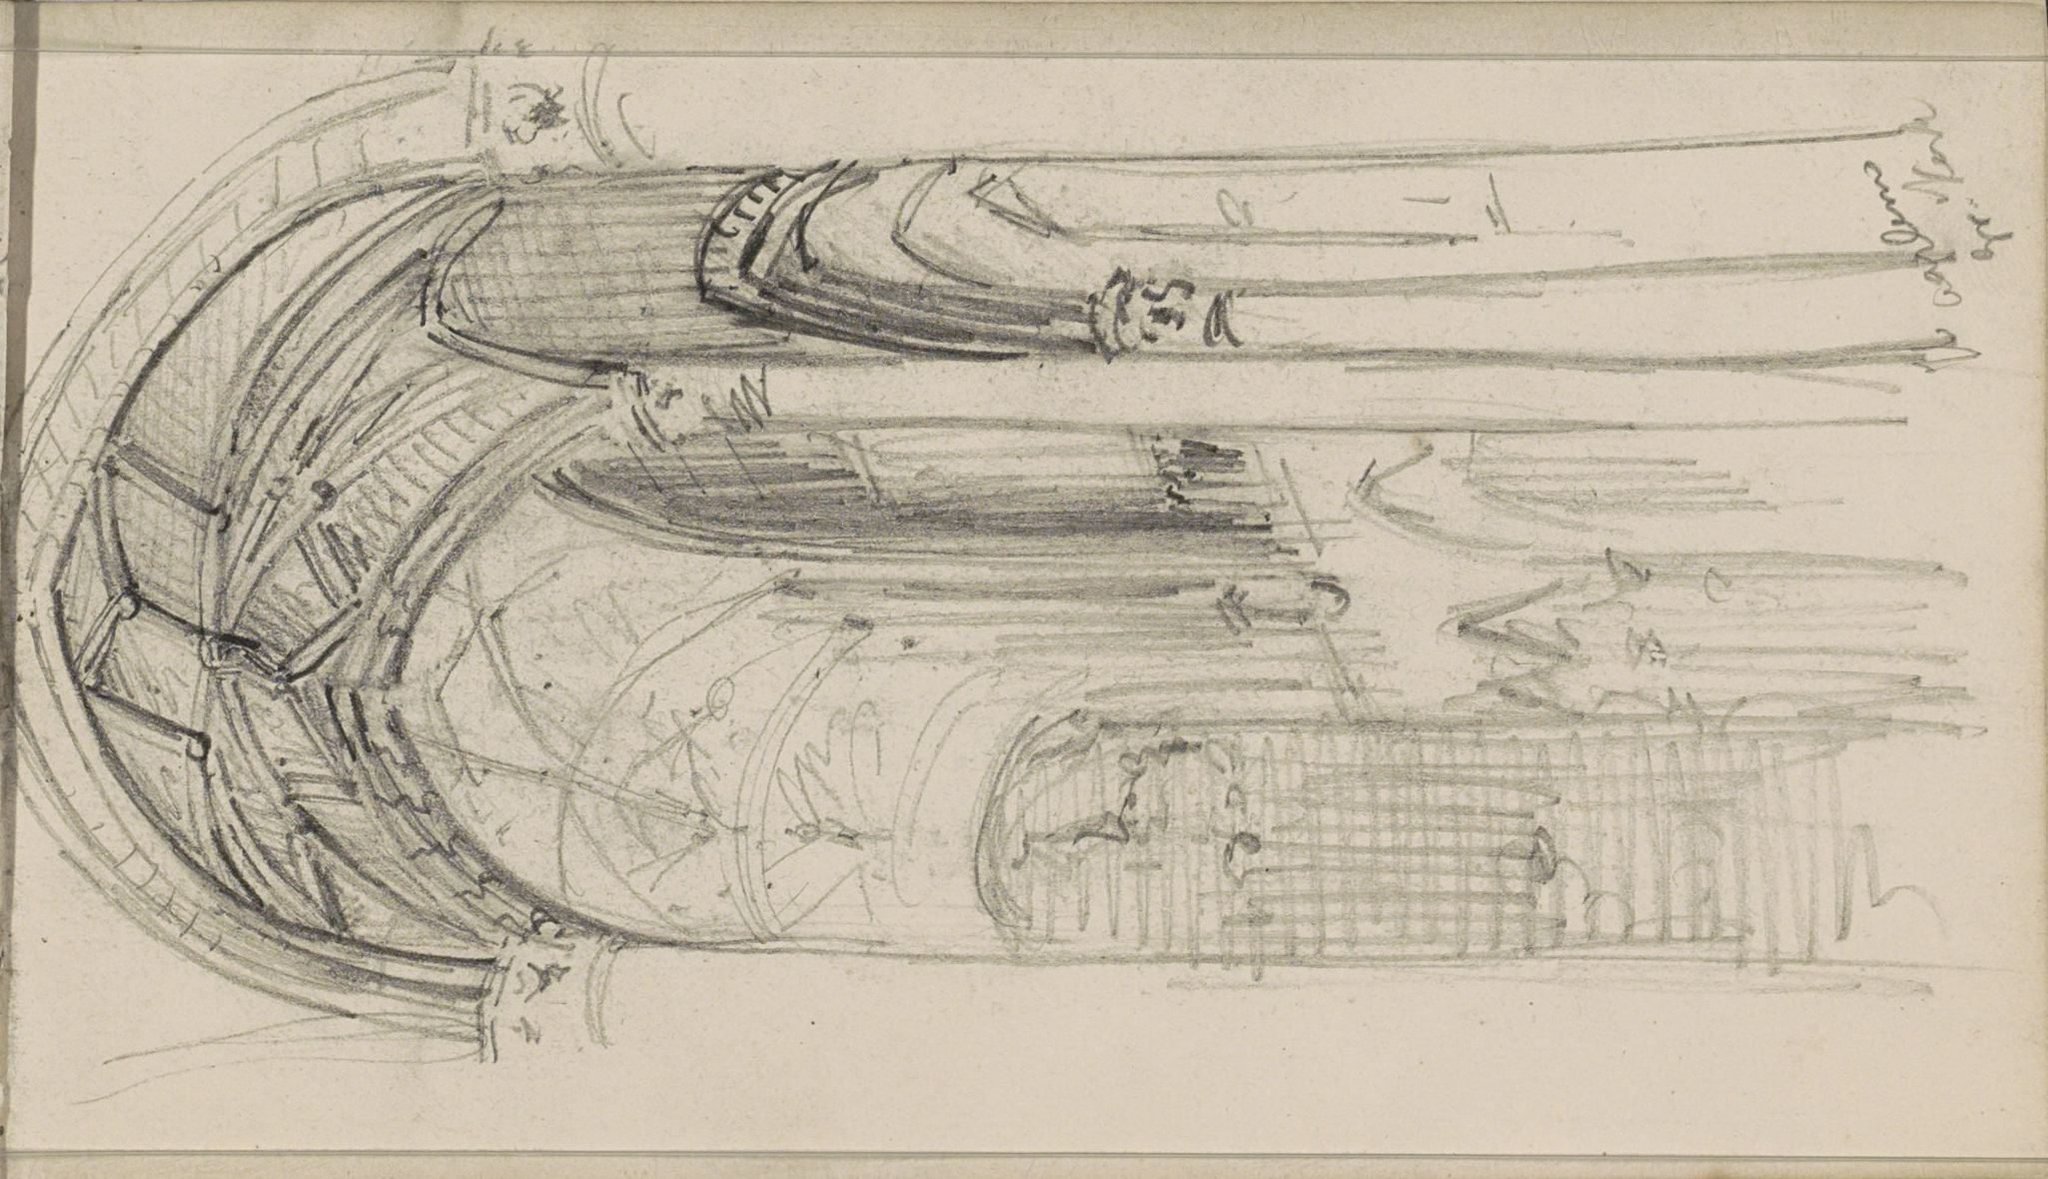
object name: sketchbook leaf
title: Interieur van de Sint-Bavokerk te Haarlem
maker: isaac gosschalk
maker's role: draughtsman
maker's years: 1838-1907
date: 1866-1868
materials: paper, pencil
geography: haarlem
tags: interior of church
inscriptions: annotation: ‘Haarlem/ gr. Kerk’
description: Blad 30 recto uit een schetsboek met 67 bladen.